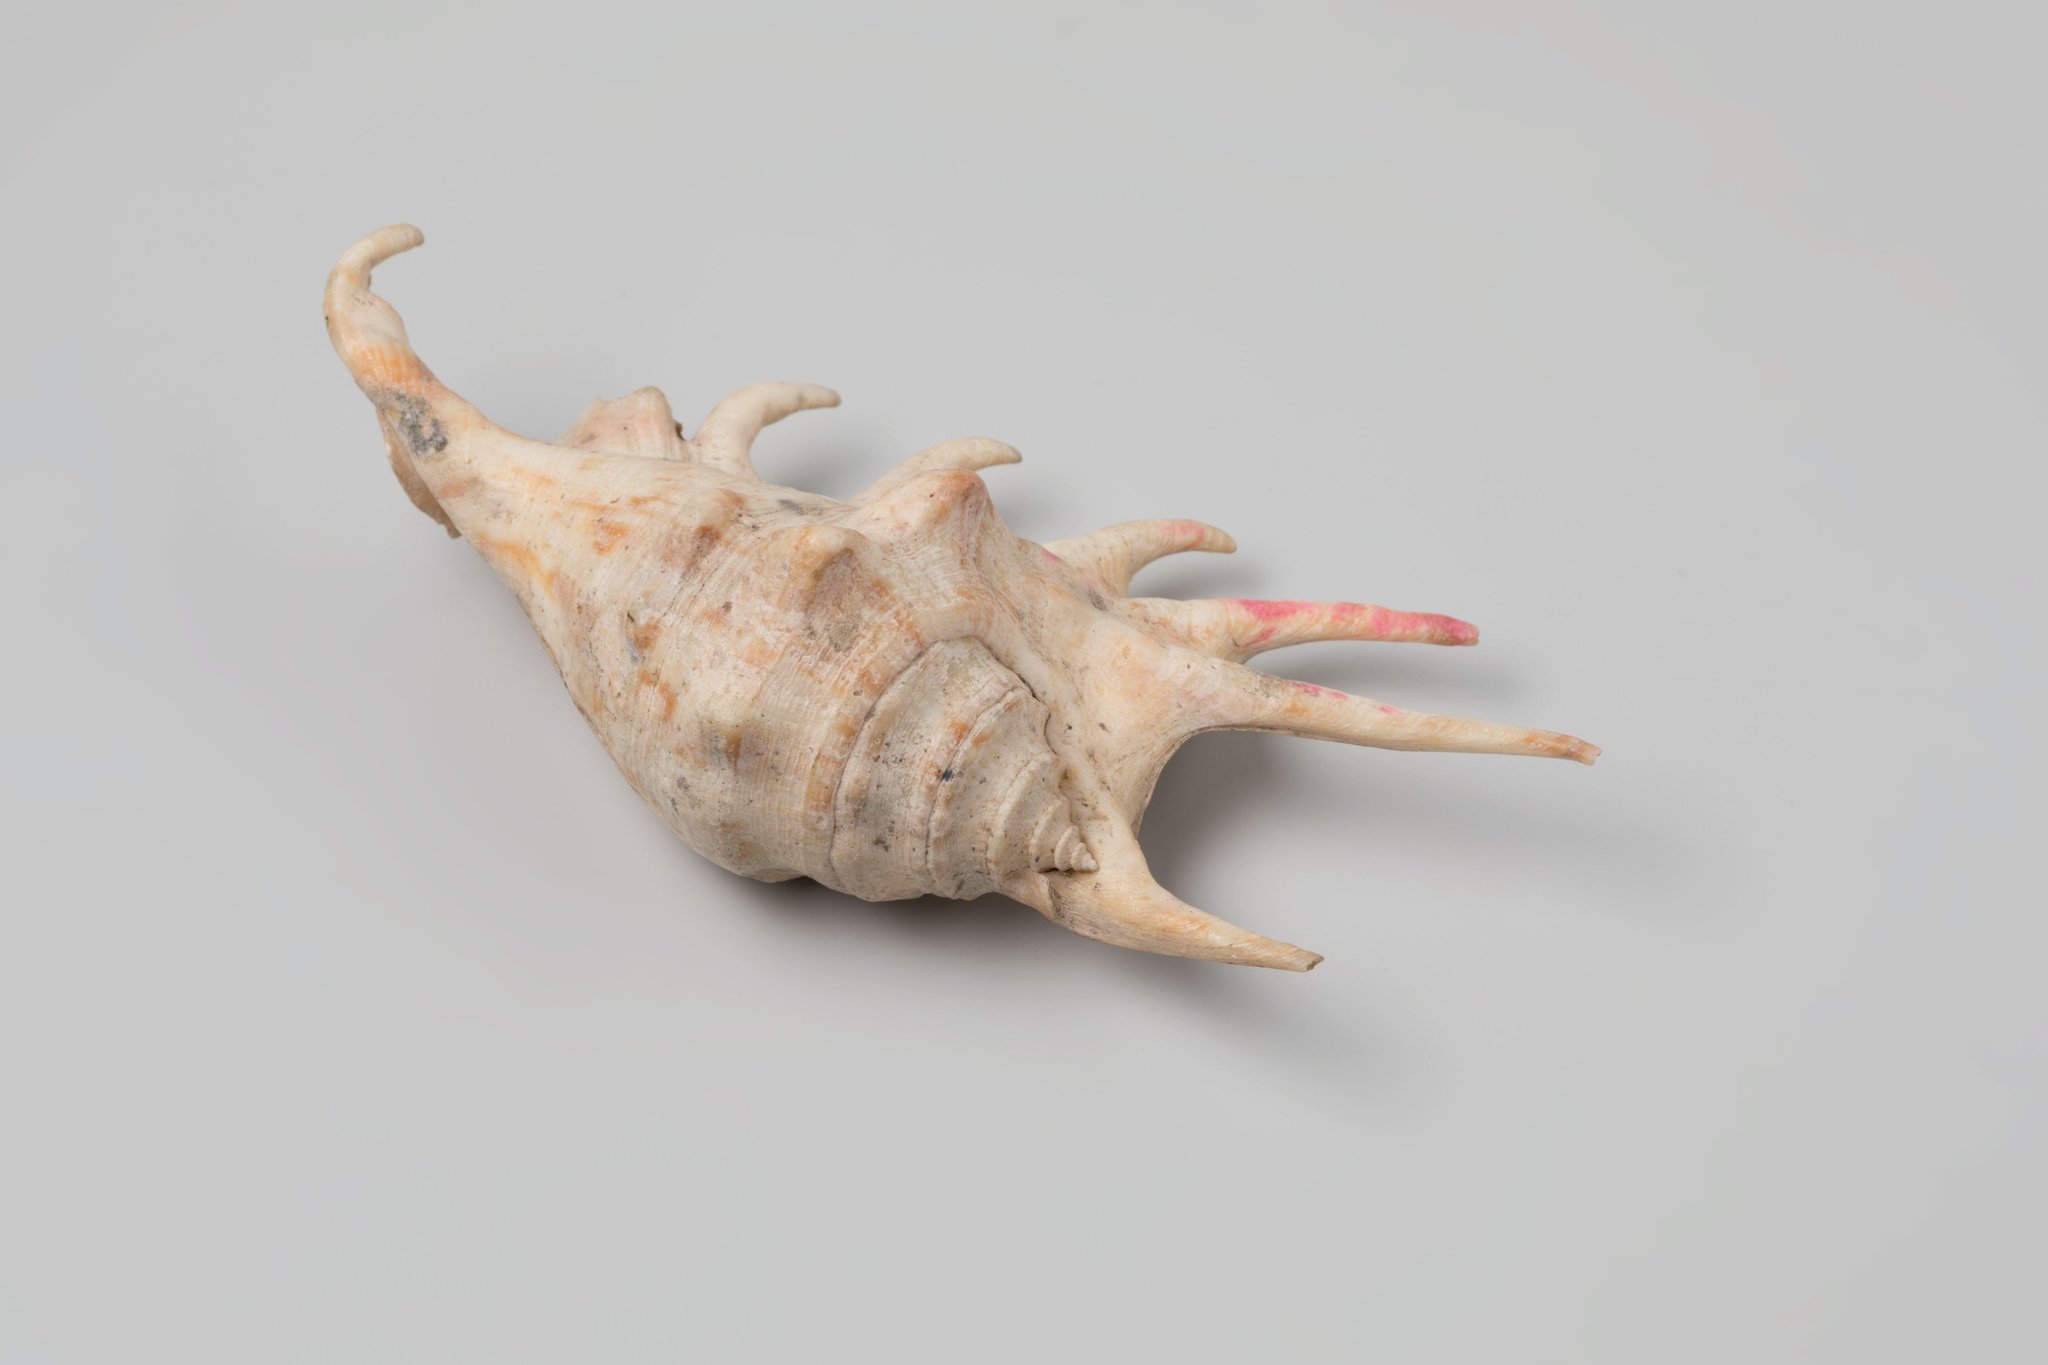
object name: lambis lambis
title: Lambis lambis shell from the wreck of the Dutch East India ship Witte Leeuw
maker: niet van toepassing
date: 1613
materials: shell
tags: verenigde oostindische compagnie, sint-helena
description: Schelp uit V.O.C.-schip de 'Witte Leeuw'. Eén van vijf schelpen.